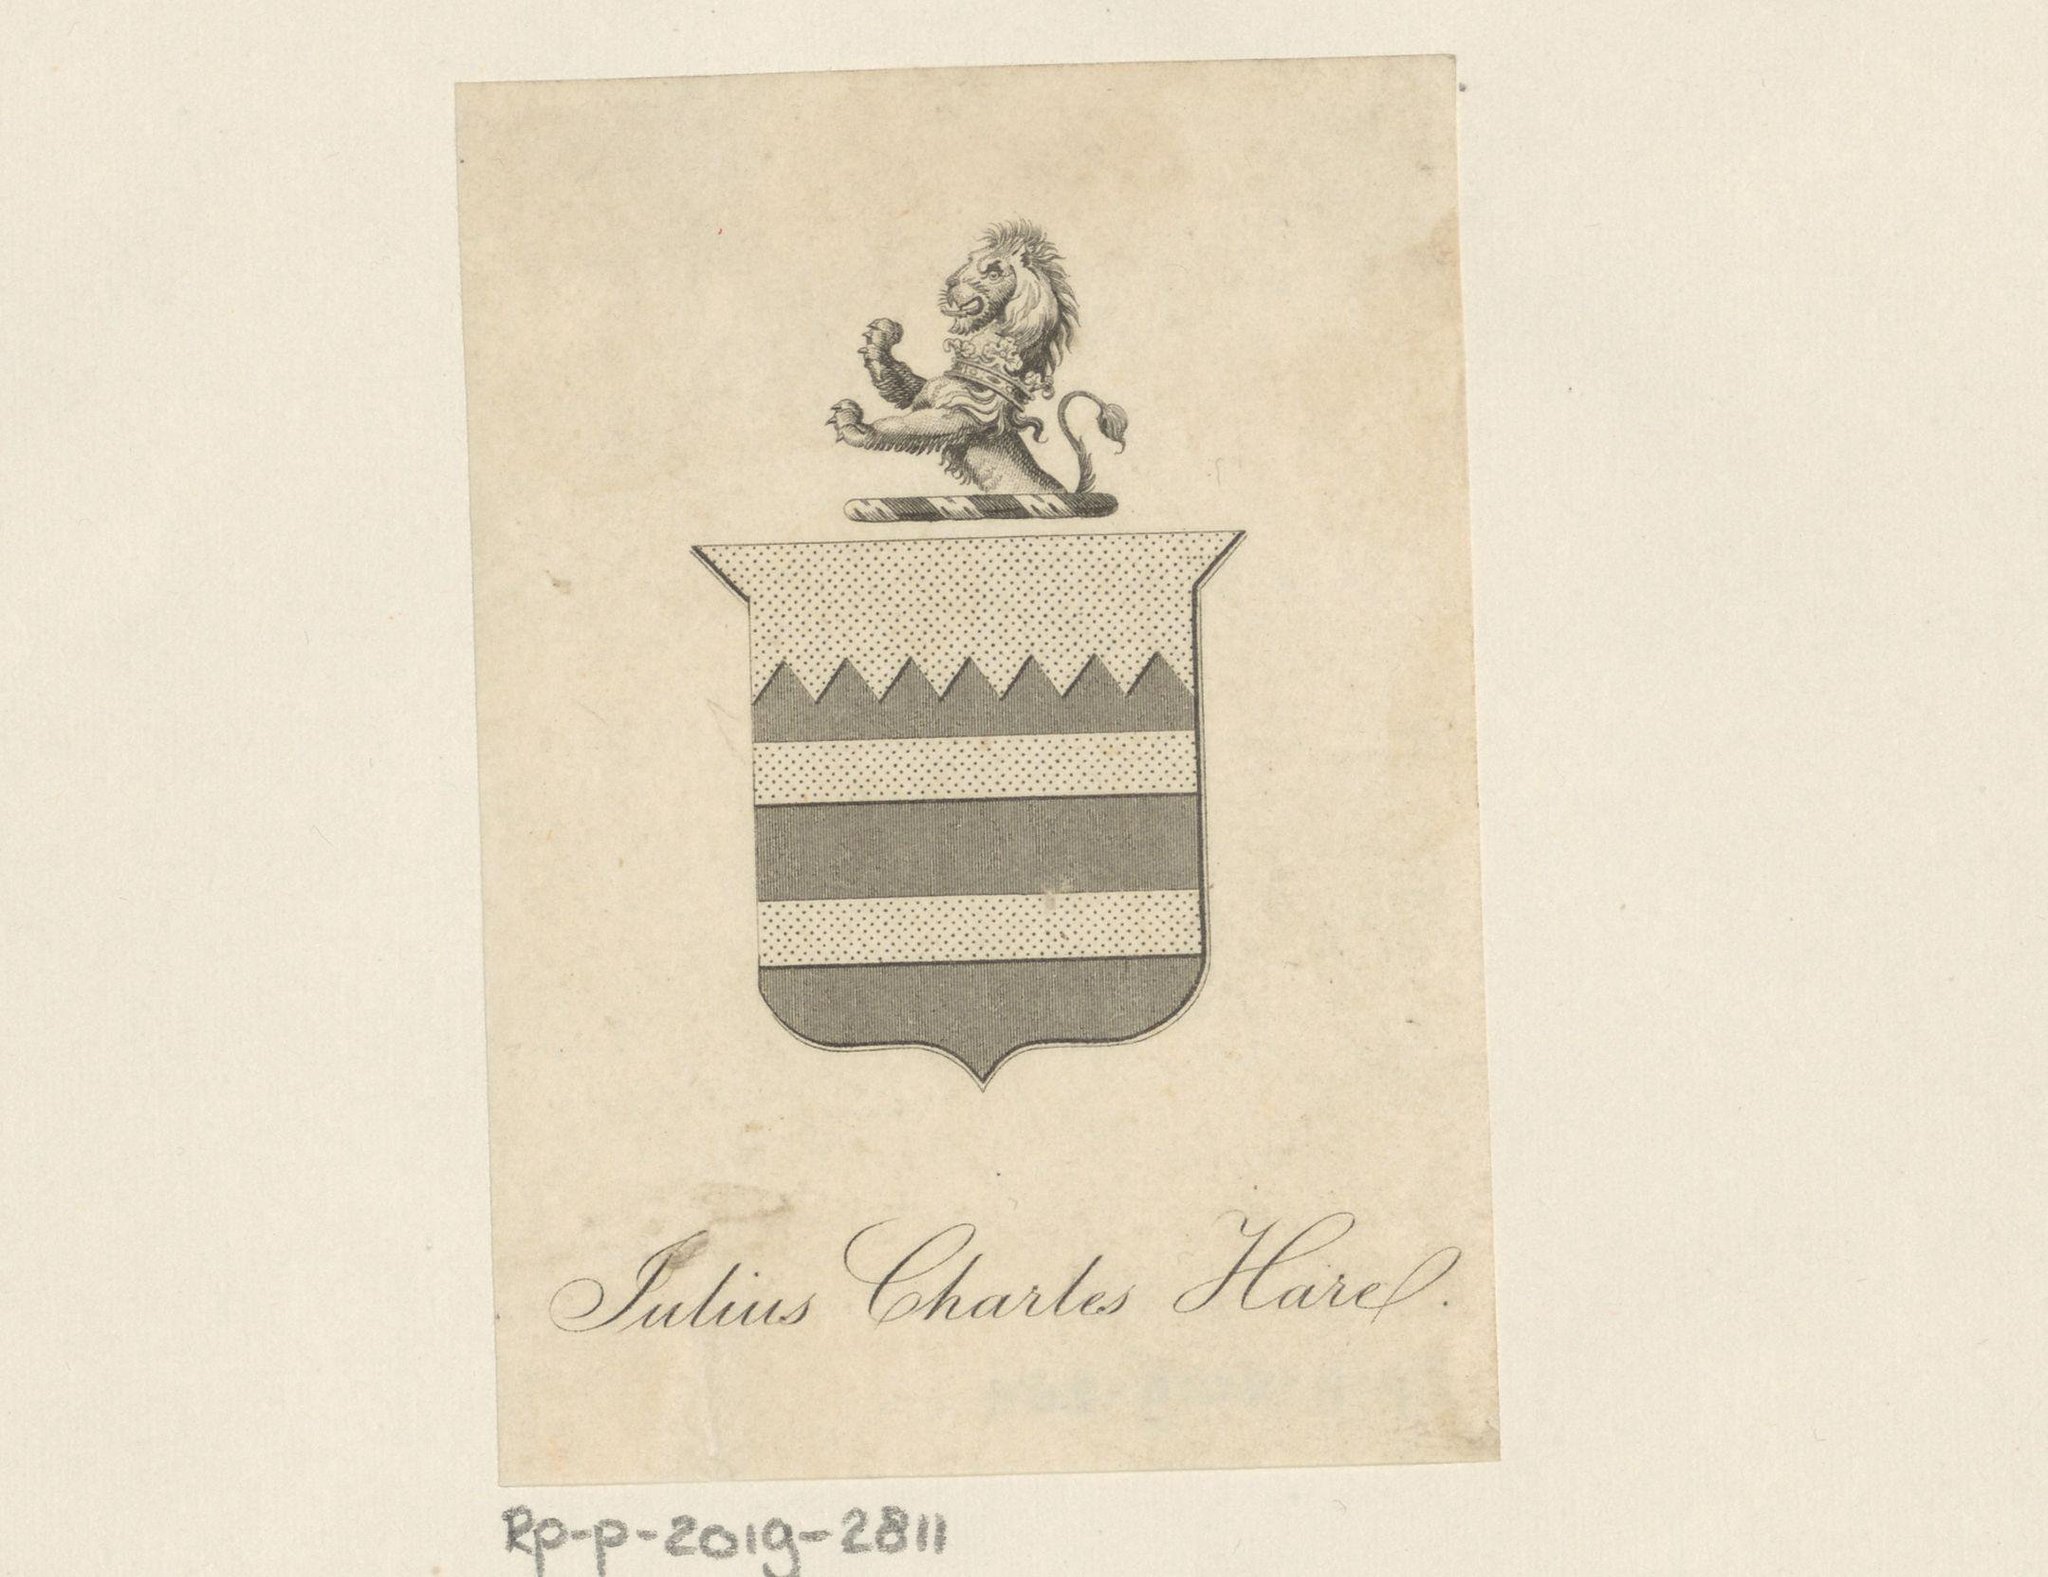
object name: bookplate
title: Ex libris van Julius Charles Hare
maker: Anonymous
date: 1805-1855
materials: paper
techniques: engraving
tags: armorial bearing, heraldry